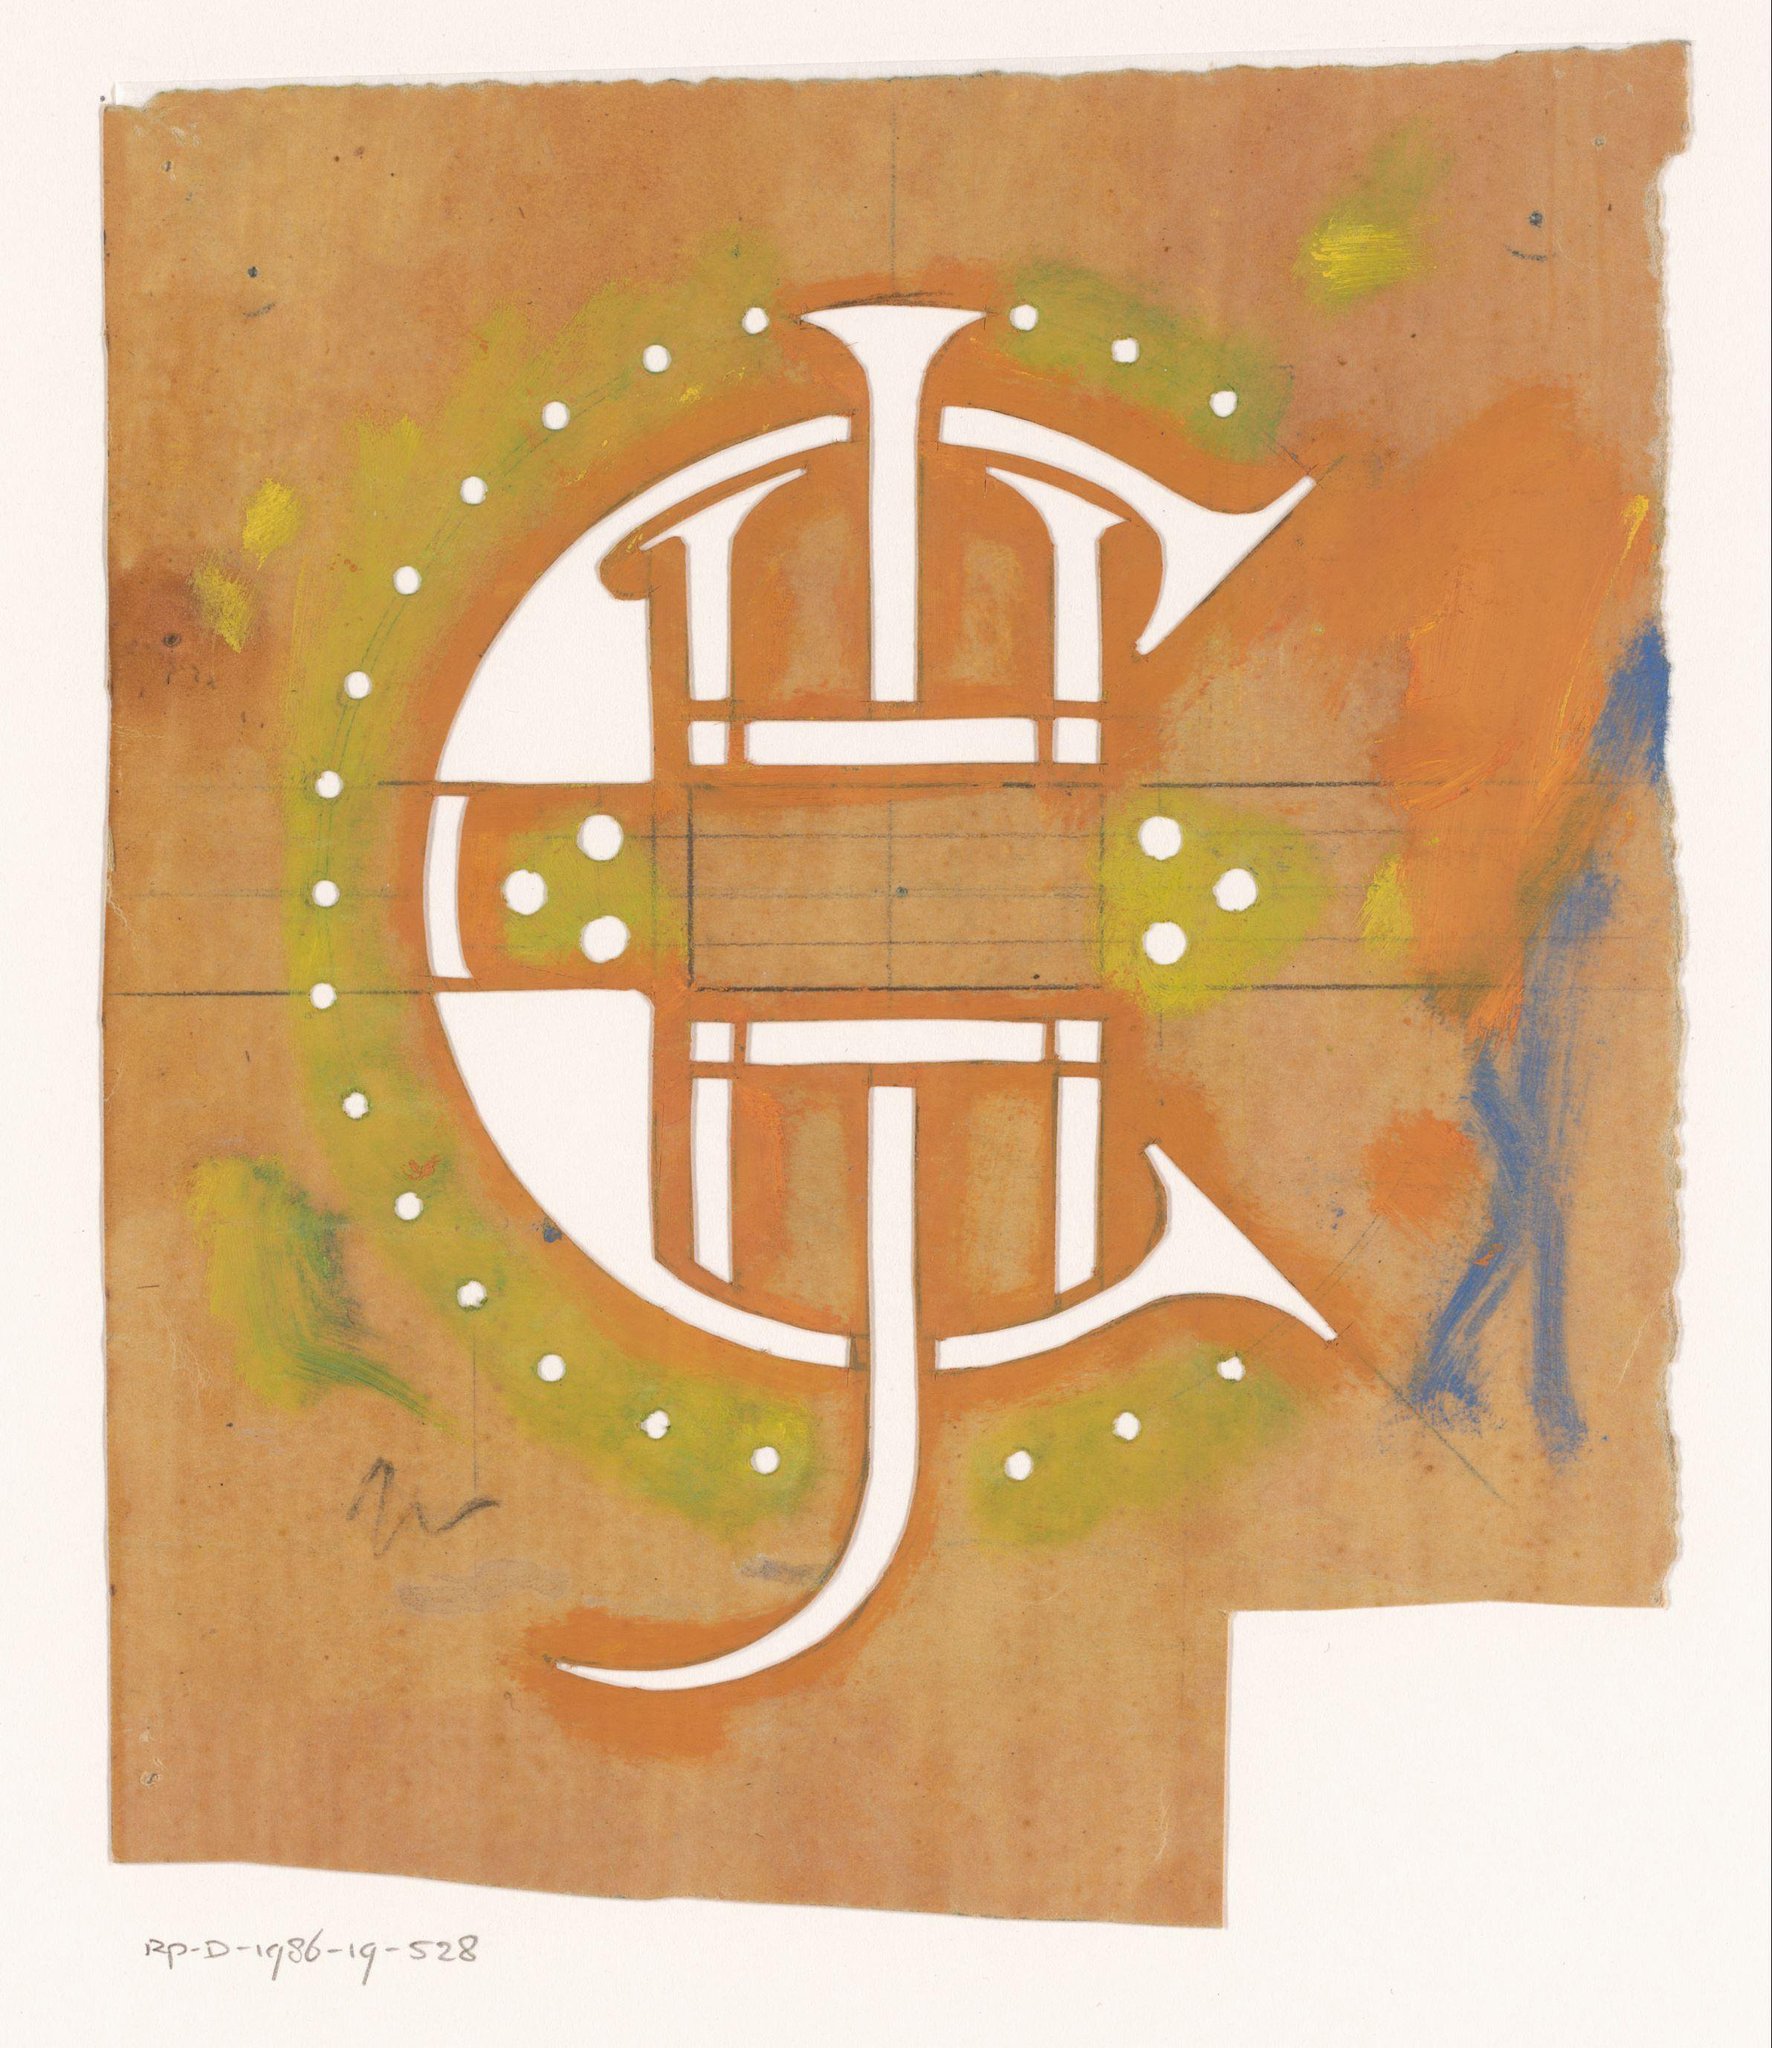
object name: template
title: Sjabloon met ornament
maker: reinier willem petrus de vries (1874-1953)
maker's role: draughtsman, print maker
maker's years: 1874-1953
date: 1884-1952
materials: paper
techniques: cutting, snipping